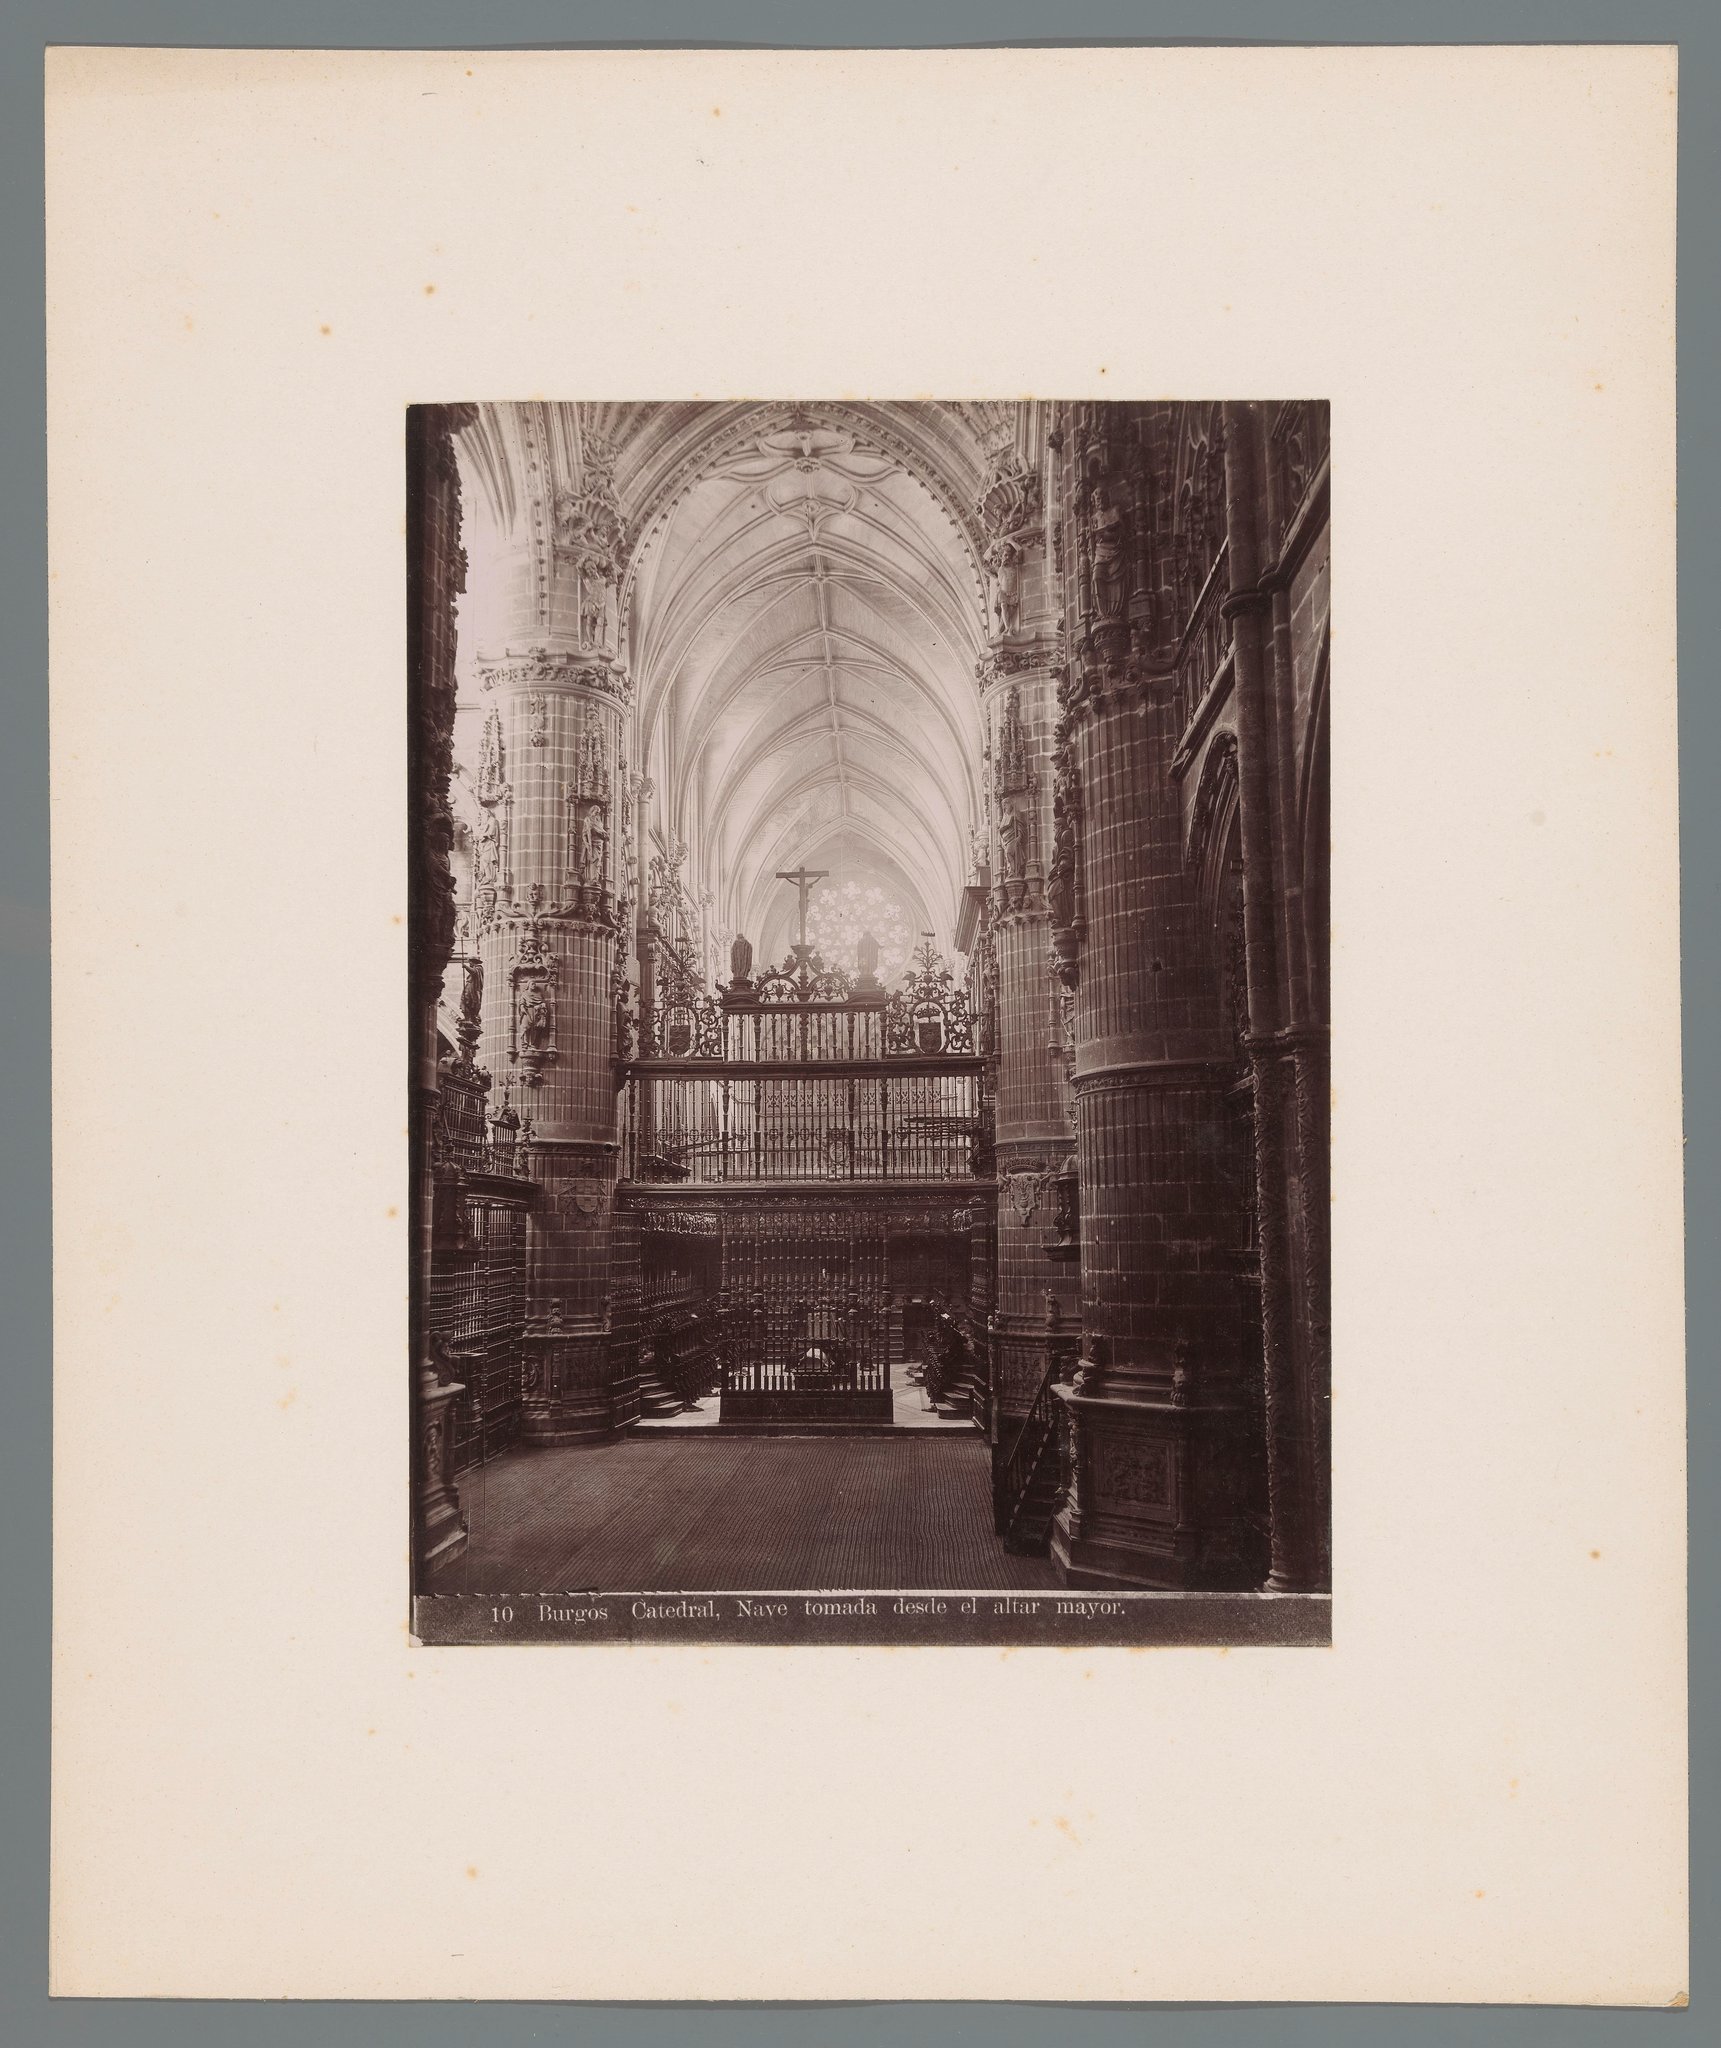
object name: photograph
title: Gezicht op het schip en het altaar van de Kathedraal van Burgos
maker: Anonymous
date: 1890-1930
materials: paper, cardboard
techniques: gelatin silver print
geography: burgos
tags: parts of church interior: nave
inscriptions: number: ‘10’